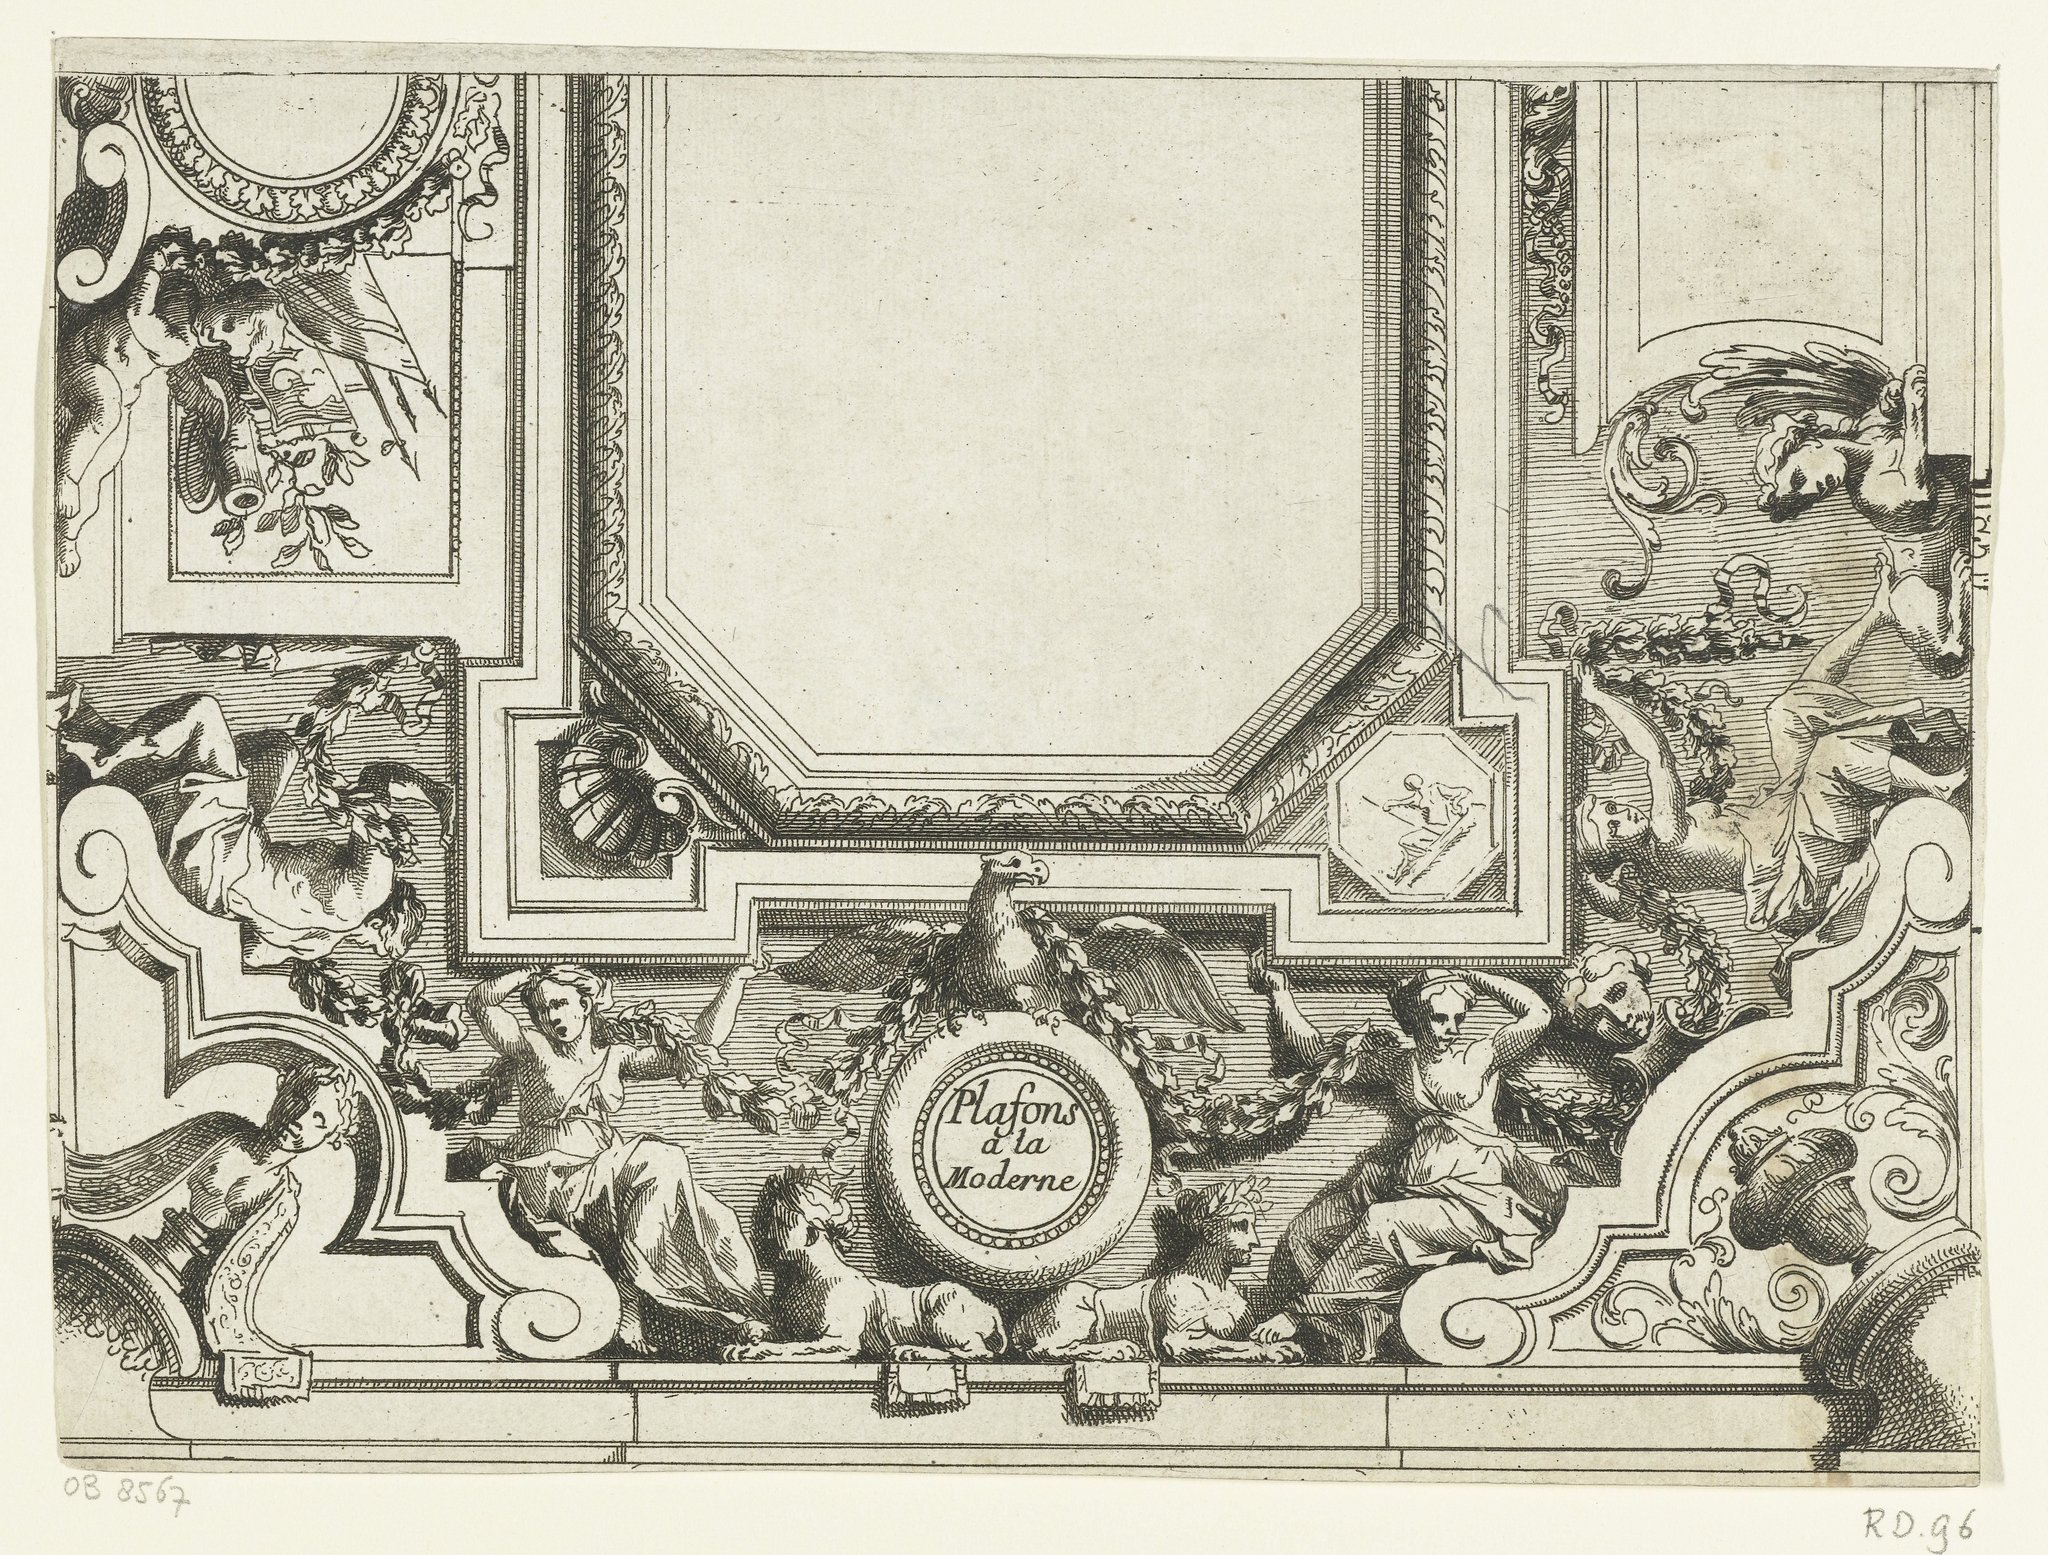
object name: titelblad, titelpagina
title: Plafonds à la moderne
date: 1634-1716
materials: paper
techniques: etching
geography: france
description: Helft van vierkant plafond met in het midden een leeg vlak en een variant voor de rechterhelft. De rand is gedecoreerd met vrouwen, sfinxen en adelaars. Blad 1 uit serie van titelblad en 11 genummerde bladen. Tweede editie.